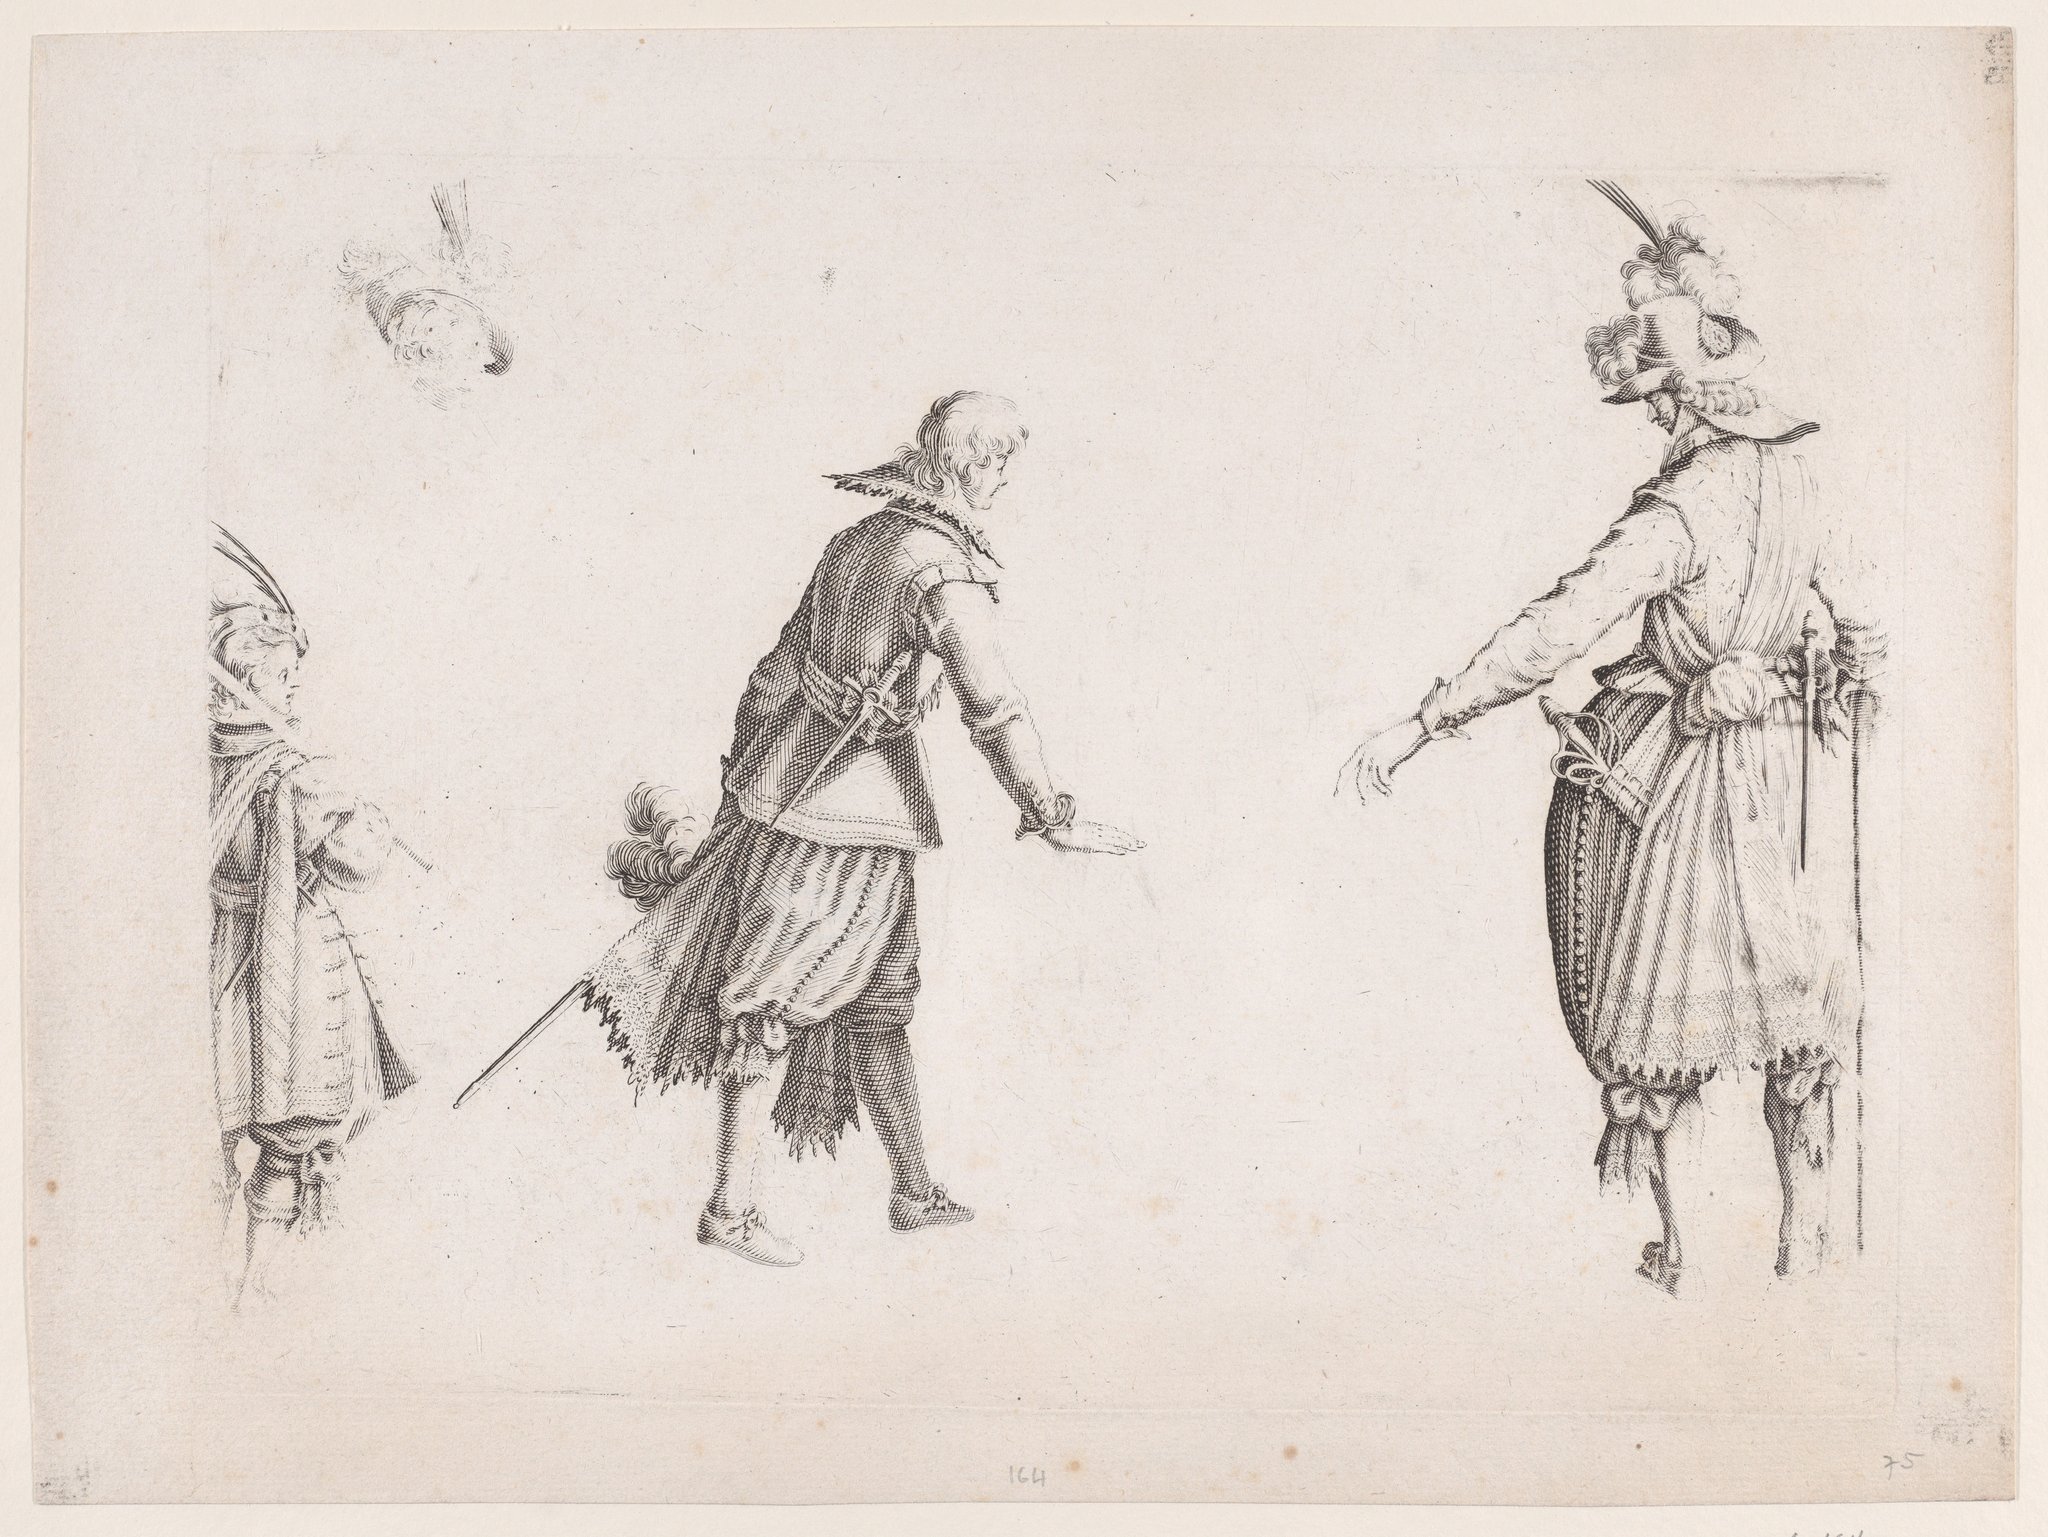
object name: print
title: L'Enrolement des Troupes (The Enlistment of the Troupes), from "La Vie de Ferdinand Ier de Médicis série appelée aussi Les Batailles des Médicis" (The Life of Ferdinand I de'Medici also called The Medici Battles)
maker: jacques callot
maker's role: artist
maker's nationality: french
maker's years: 1592-1635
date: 1614-1620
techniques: engraving